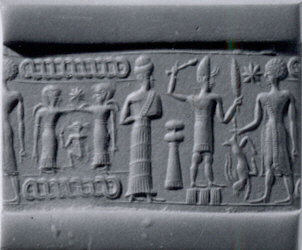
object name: cylinder seal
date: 1820-1730 BCE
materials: mineral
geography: syria